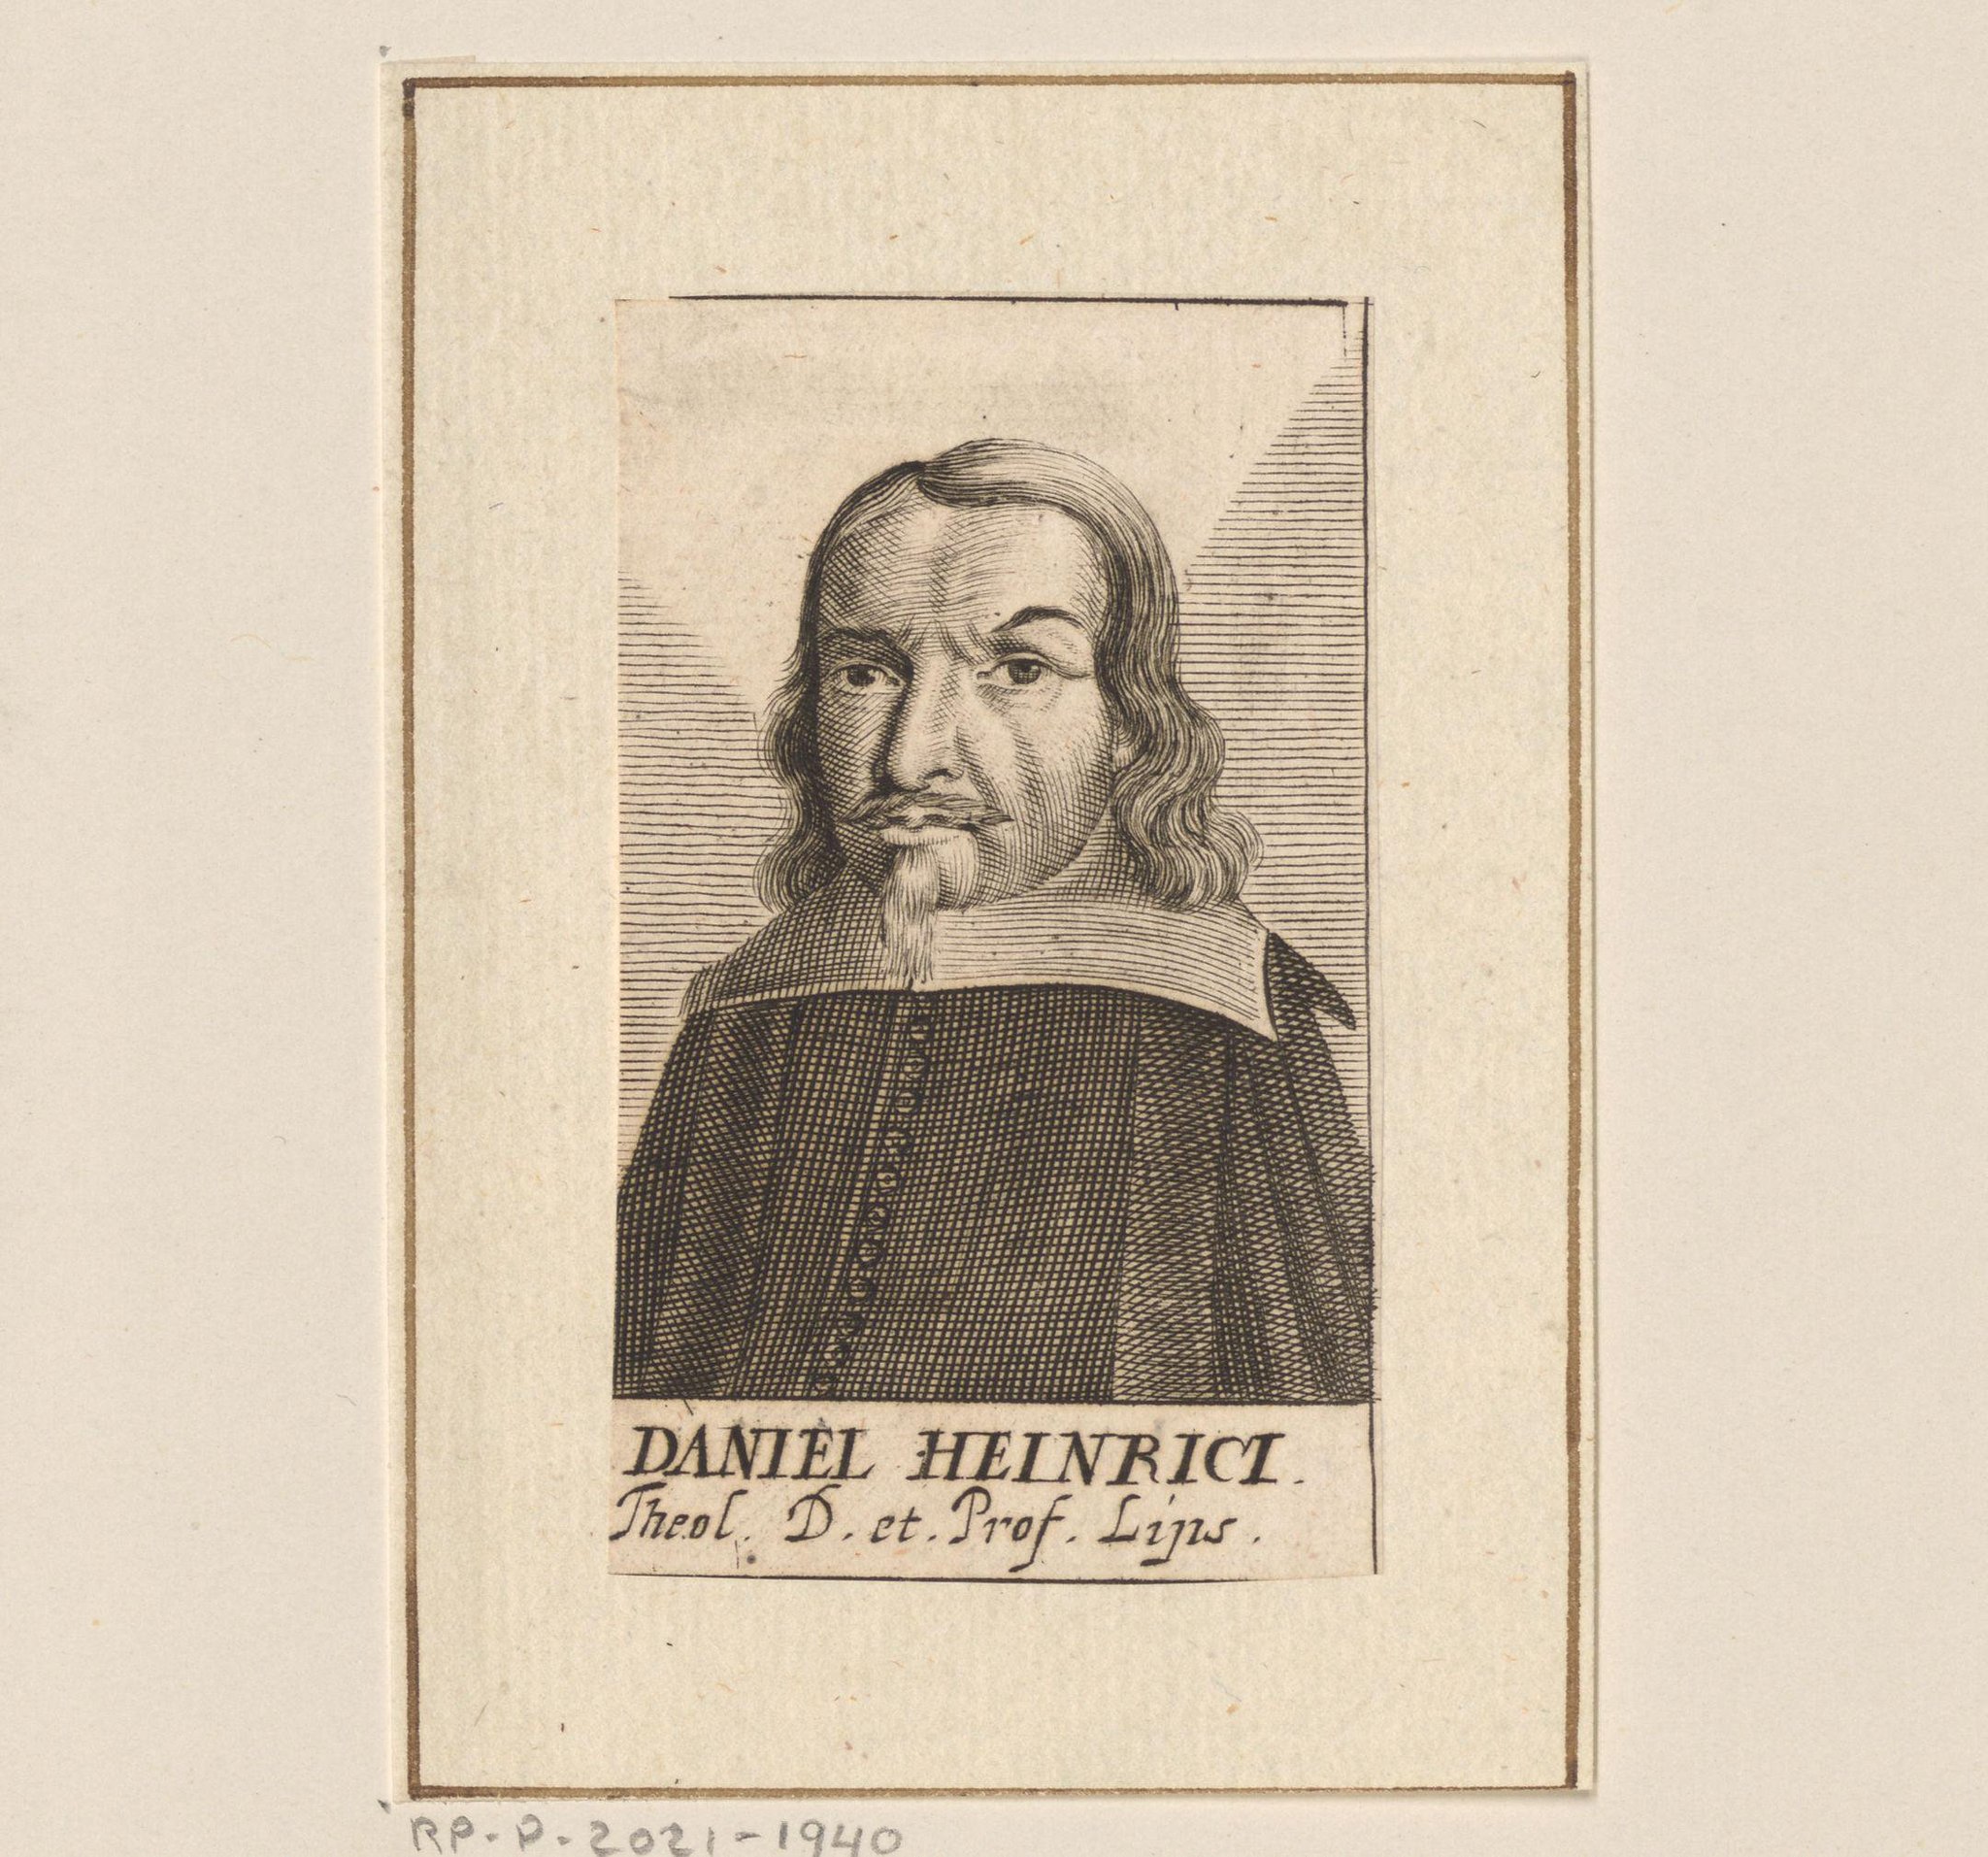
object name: book illustration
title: Portret van Daniel Heinrici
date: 1688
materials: paper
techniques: engraving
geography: nuremberg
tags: chemnitz, theologian, historical persons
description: Prent uit: Freher, Paul. Theatrum virorum eruditione clarorum. Neurenberg: Johann Hoffmann, 1688.